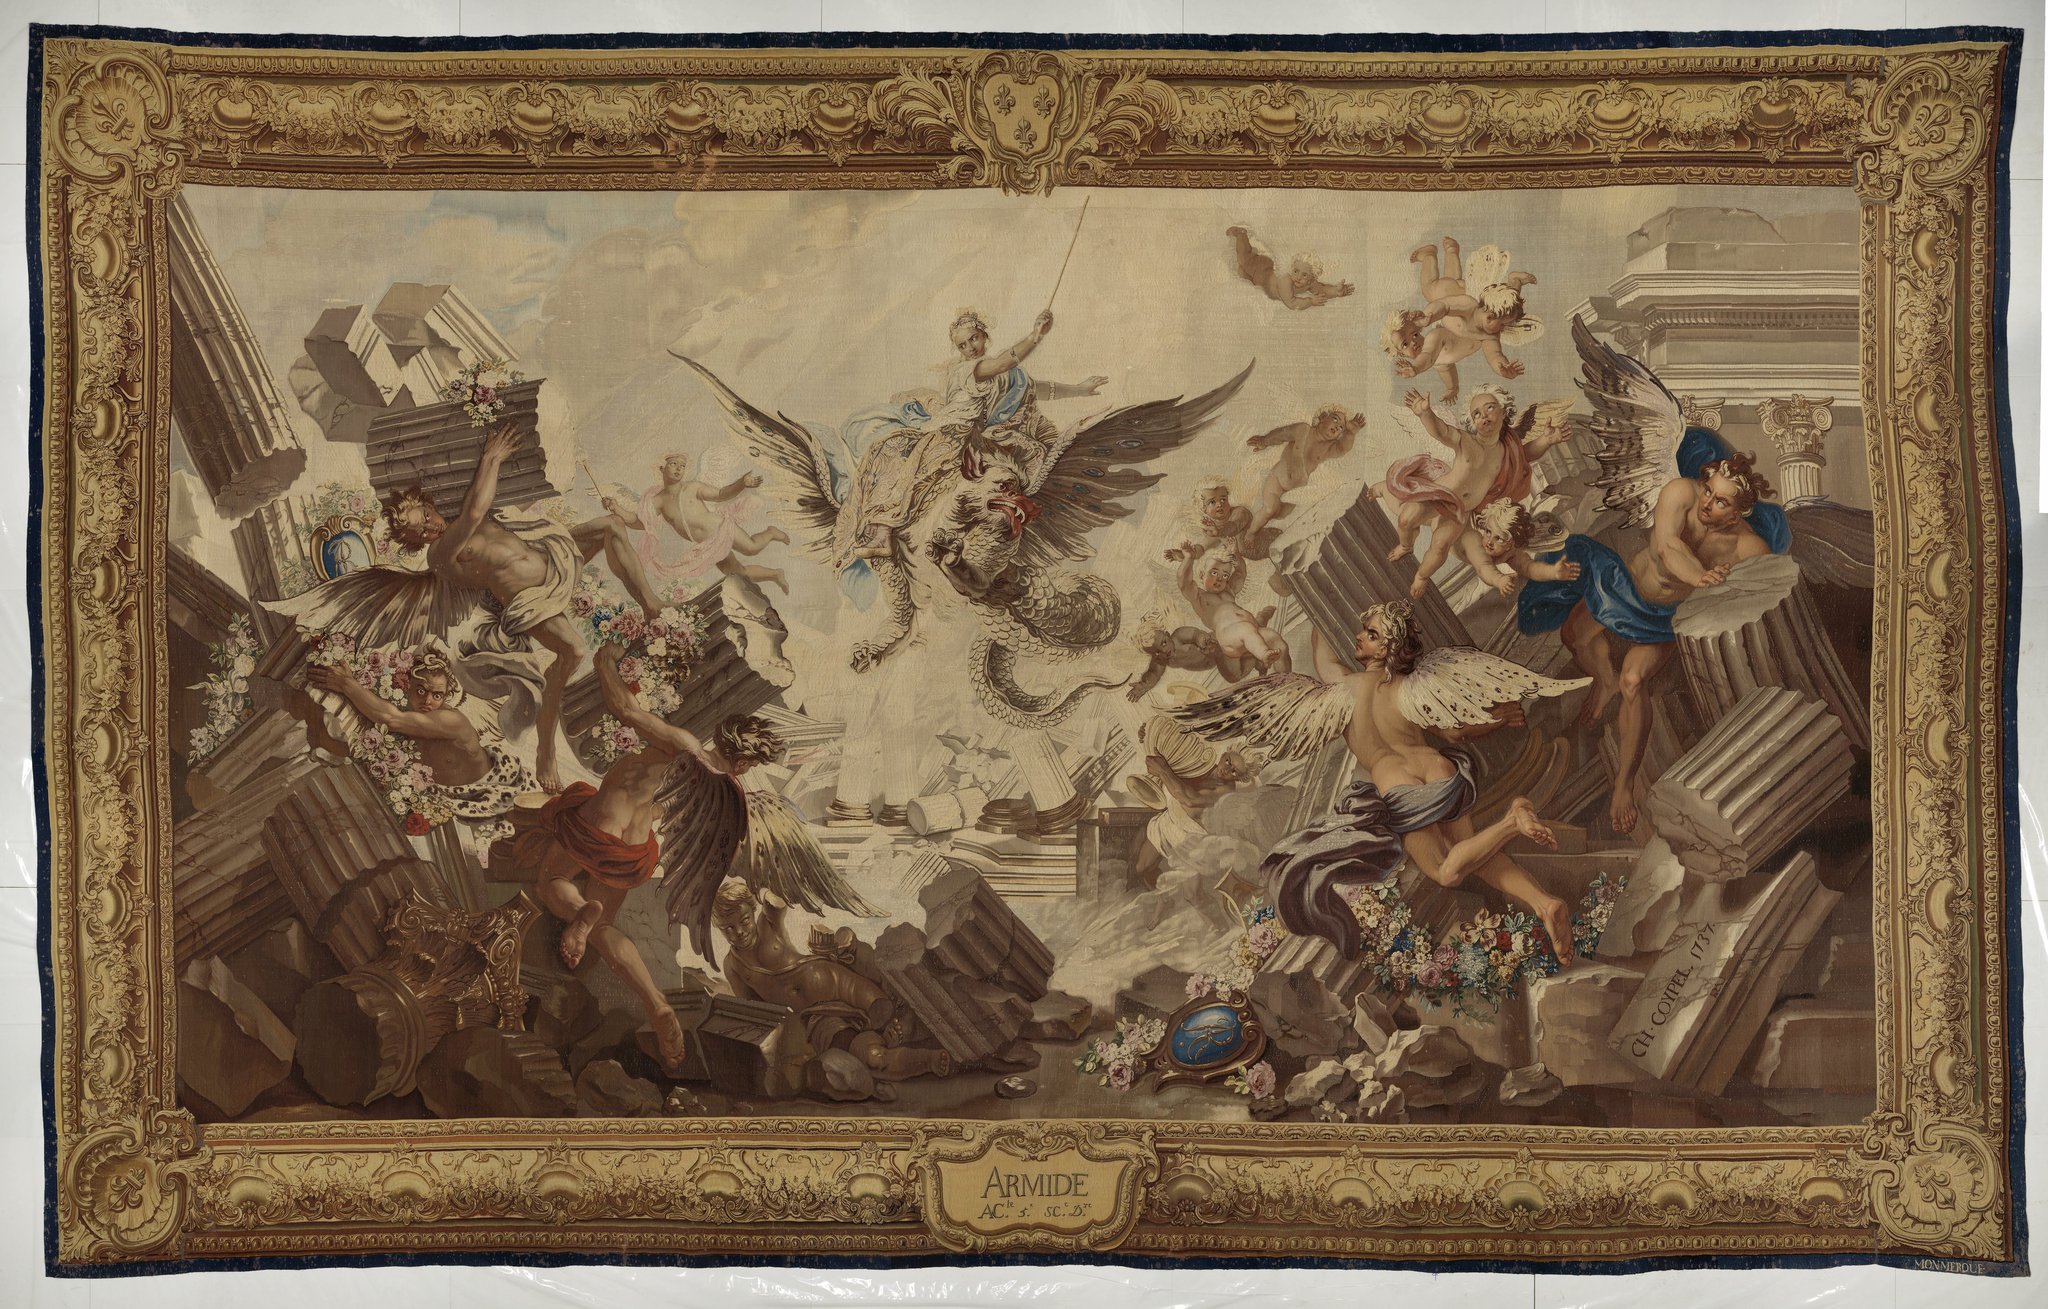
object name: tapestry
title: The Destruction of Armida's Palace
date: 1741-1748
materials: silk, wool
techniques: tapestry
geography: france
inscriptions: inscription: ‘ARMIDE ACte 5, sc.e Dre’, signature: ‘CH.COYPEL. 1737’, signature: ‘MONMERQUE’, signature: ‘MONMERQUE’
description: Tapestry, one of a set of four with scenes from the opera Rinaldo et Armida (1686) by P. Quinault and J.B. Lully, inspired by the epic poem Gerusalemme Liberata by Torquato Tasso. Wool and silk, tapestry woven Paris, 1741 - 1749, Manufacture Royale des Gobelins, workshop of Mathieu Monmerqué and Pierre François Cozette. The scene of Armida destroying her magical palace is after a design by Charles Coypel, 1737, the borders after one by Pierre Josse Perrot, 1738. Presented by Louis XV to the Spanish ambassador Paul-Gérôme Grimaldi in 1763. Given by the Commissie voor Fotoverkoop, 1955.